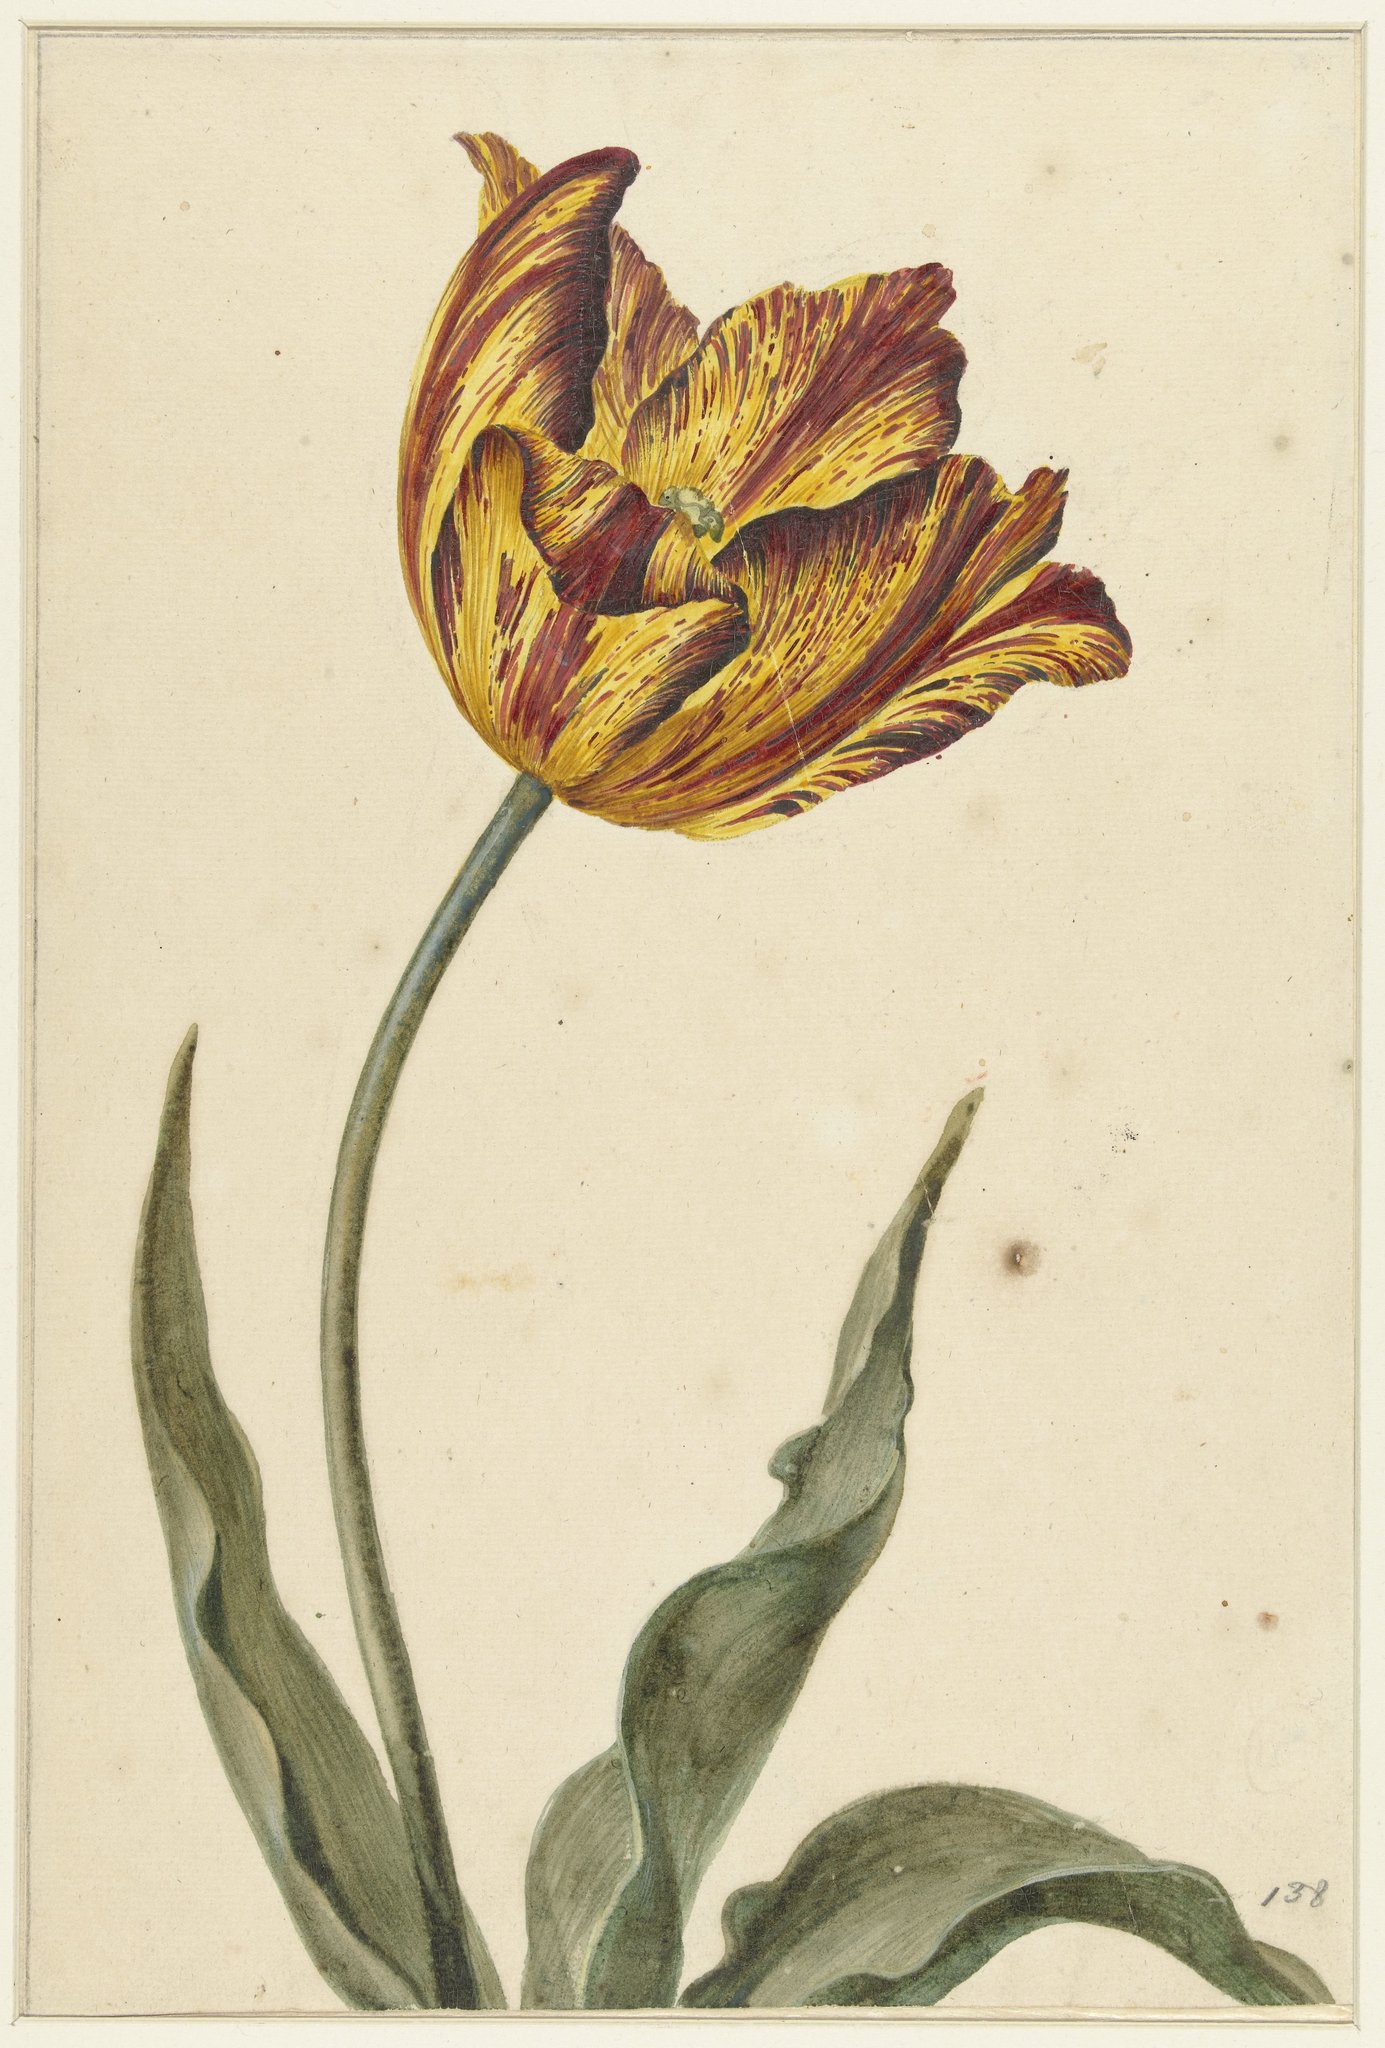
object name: drawing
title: Geel-oranje-rode tulp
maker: Anonymous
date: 1700-1800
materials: paint, ink, paper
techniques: brush, pen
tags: flowers: tulip